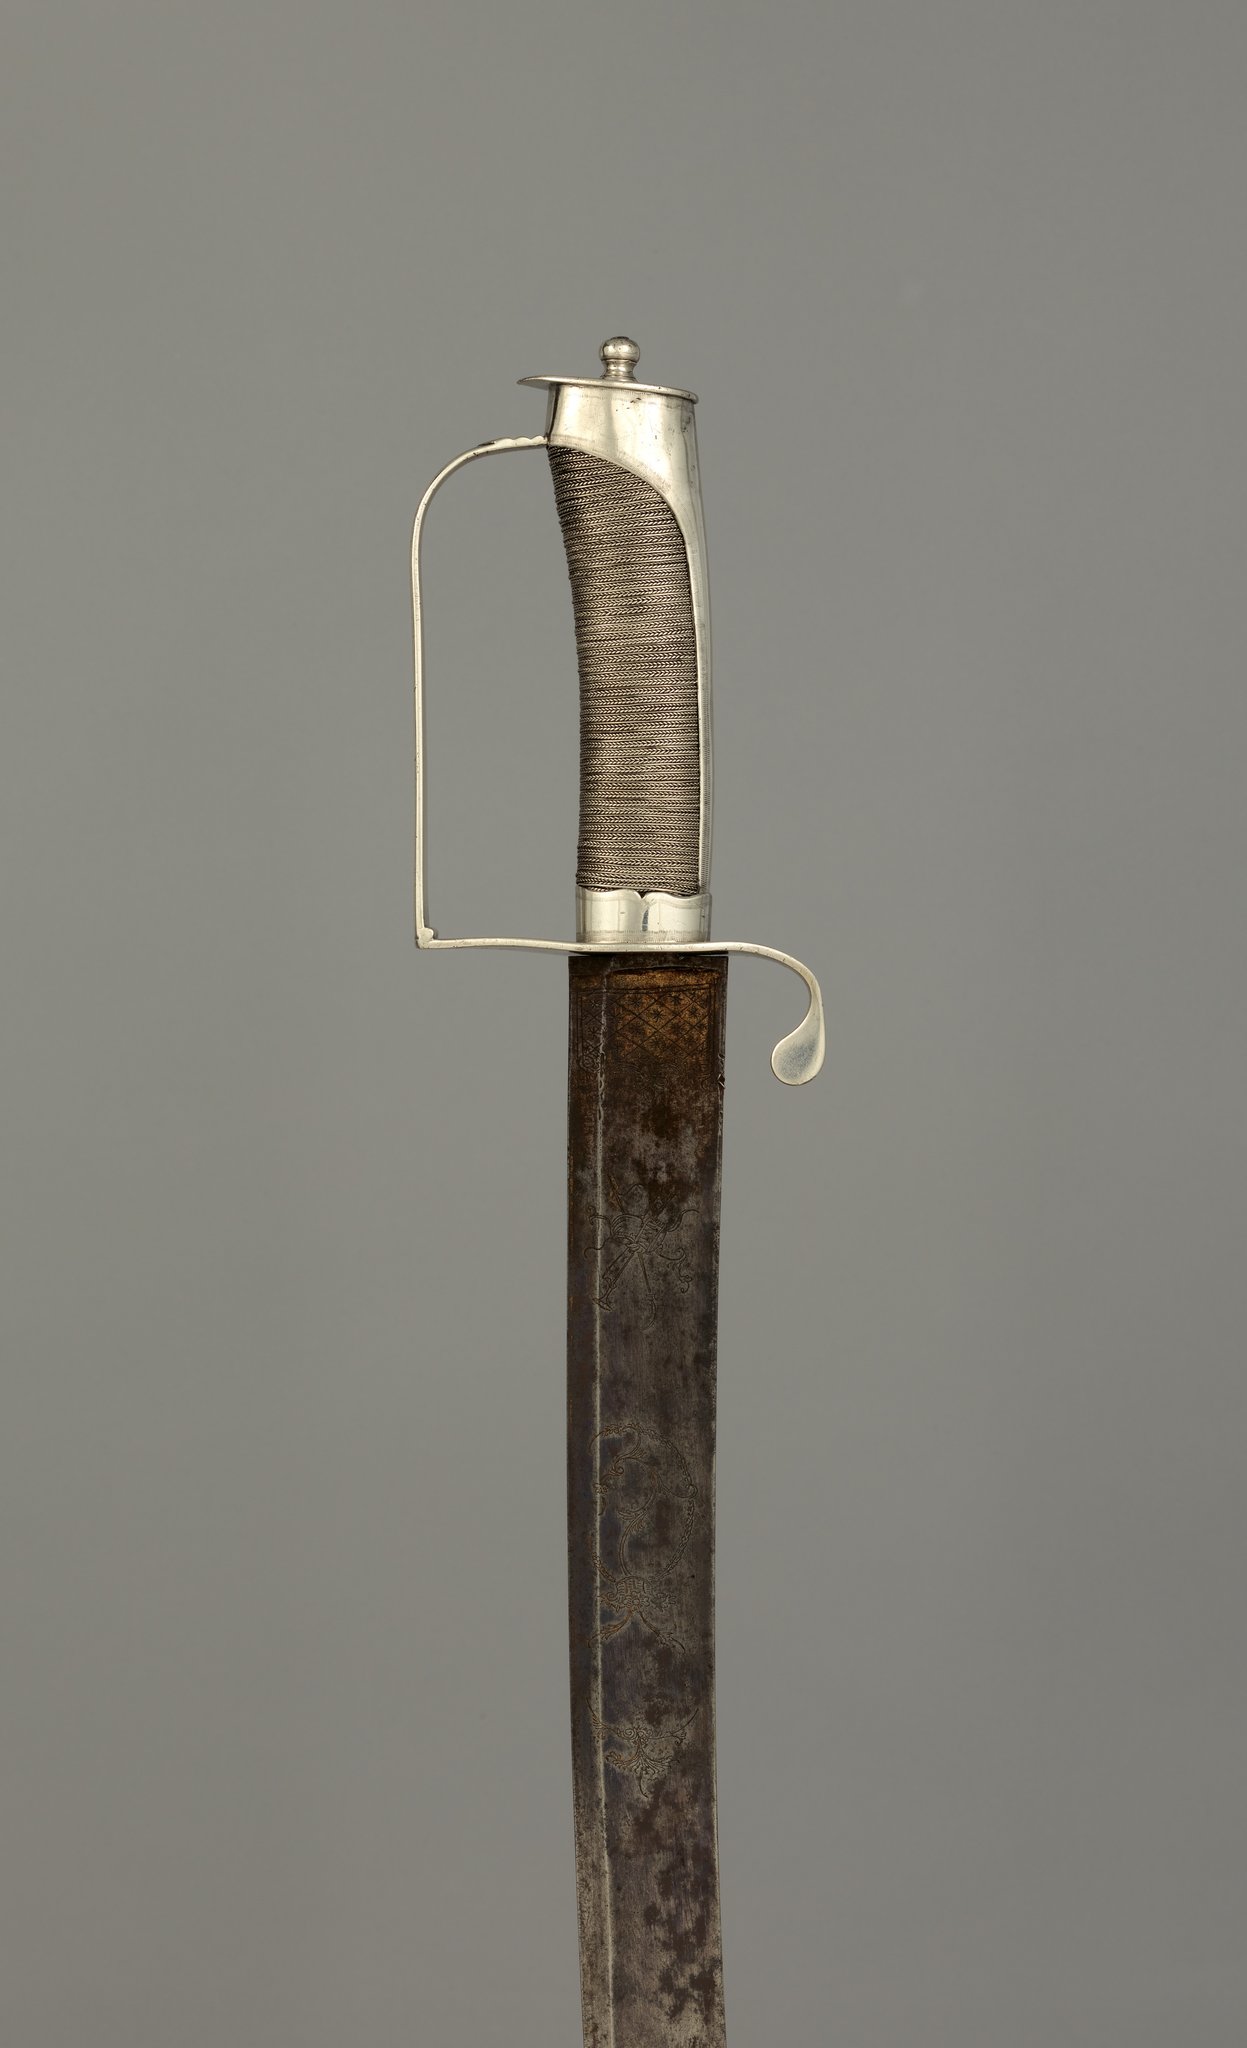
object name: sword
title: Cavalry Officer's Saber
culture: american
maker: john lynch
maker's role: silversmith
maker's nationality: american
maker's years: 1761-1848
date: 1810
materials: gold, silver, steel, wood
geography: united states